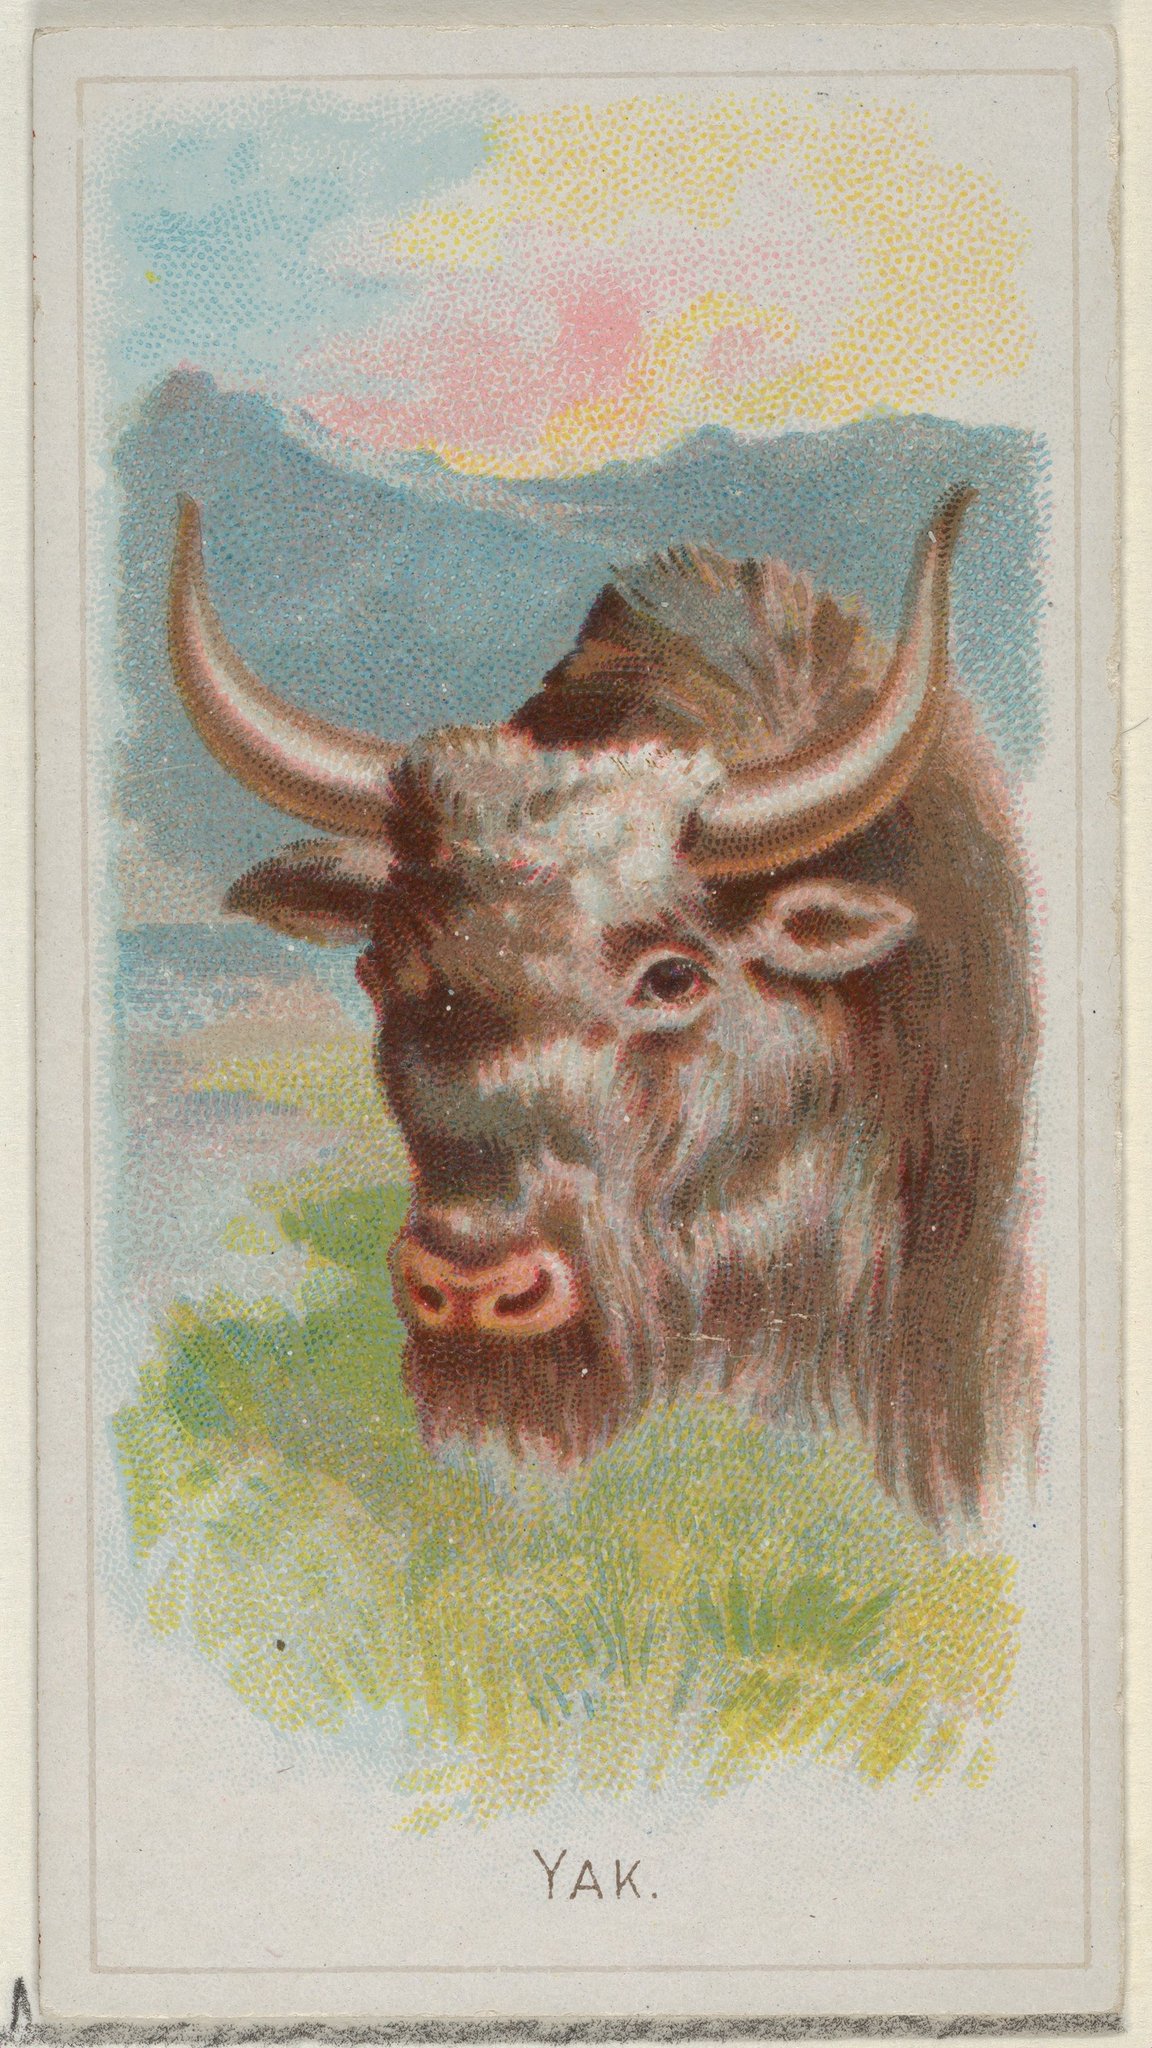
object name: print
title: Yak, from the Wild Animals of the World series (N25) for Allen & Ginter Cigarettes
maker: allen & ginter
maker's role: publisher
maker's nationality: american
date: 1888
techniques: color lithograph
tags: animals